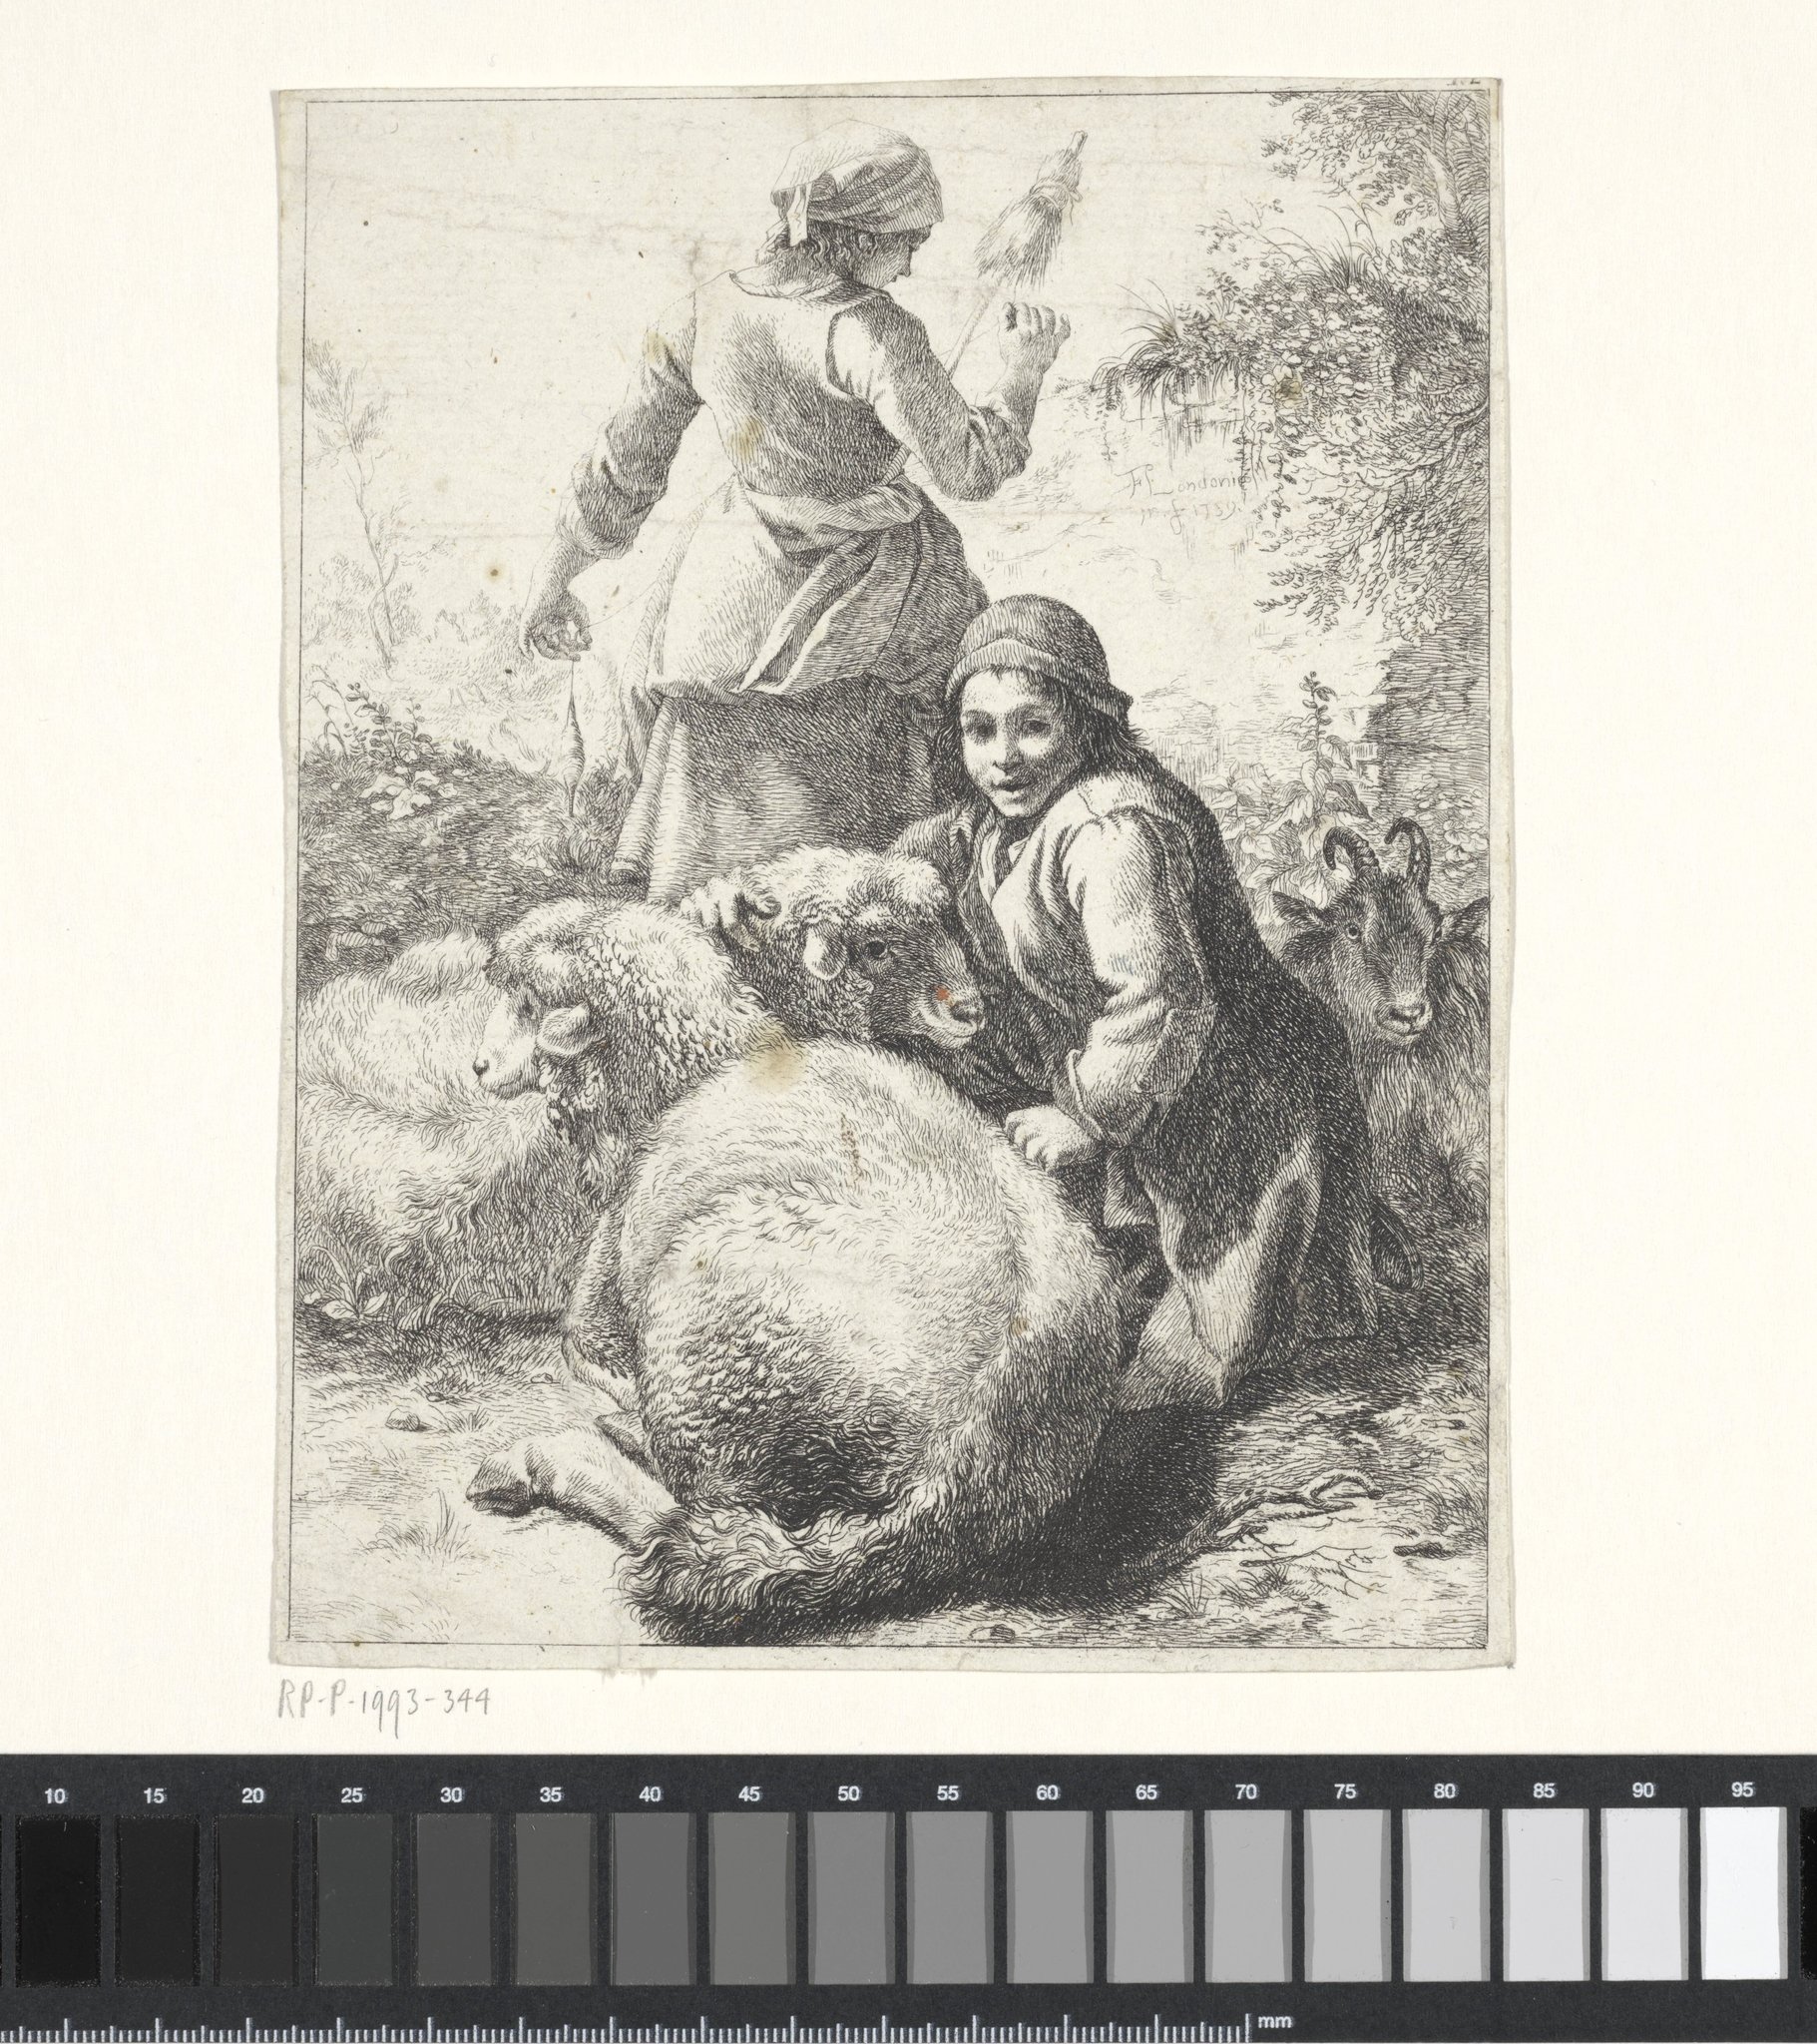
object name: print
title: Herder en herderin met twee schapen en een geit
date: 1759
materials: paper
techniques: etching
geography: italy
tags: herding, herdsman, herdswoman, shepherd, shepherdess, cowherd, etc., herd, flock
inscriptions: collector's mark: Lugt 2228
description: Een zittende hedersjongen bij twee schapen en een geit. Achter hem een staand meisje met een spinklos.